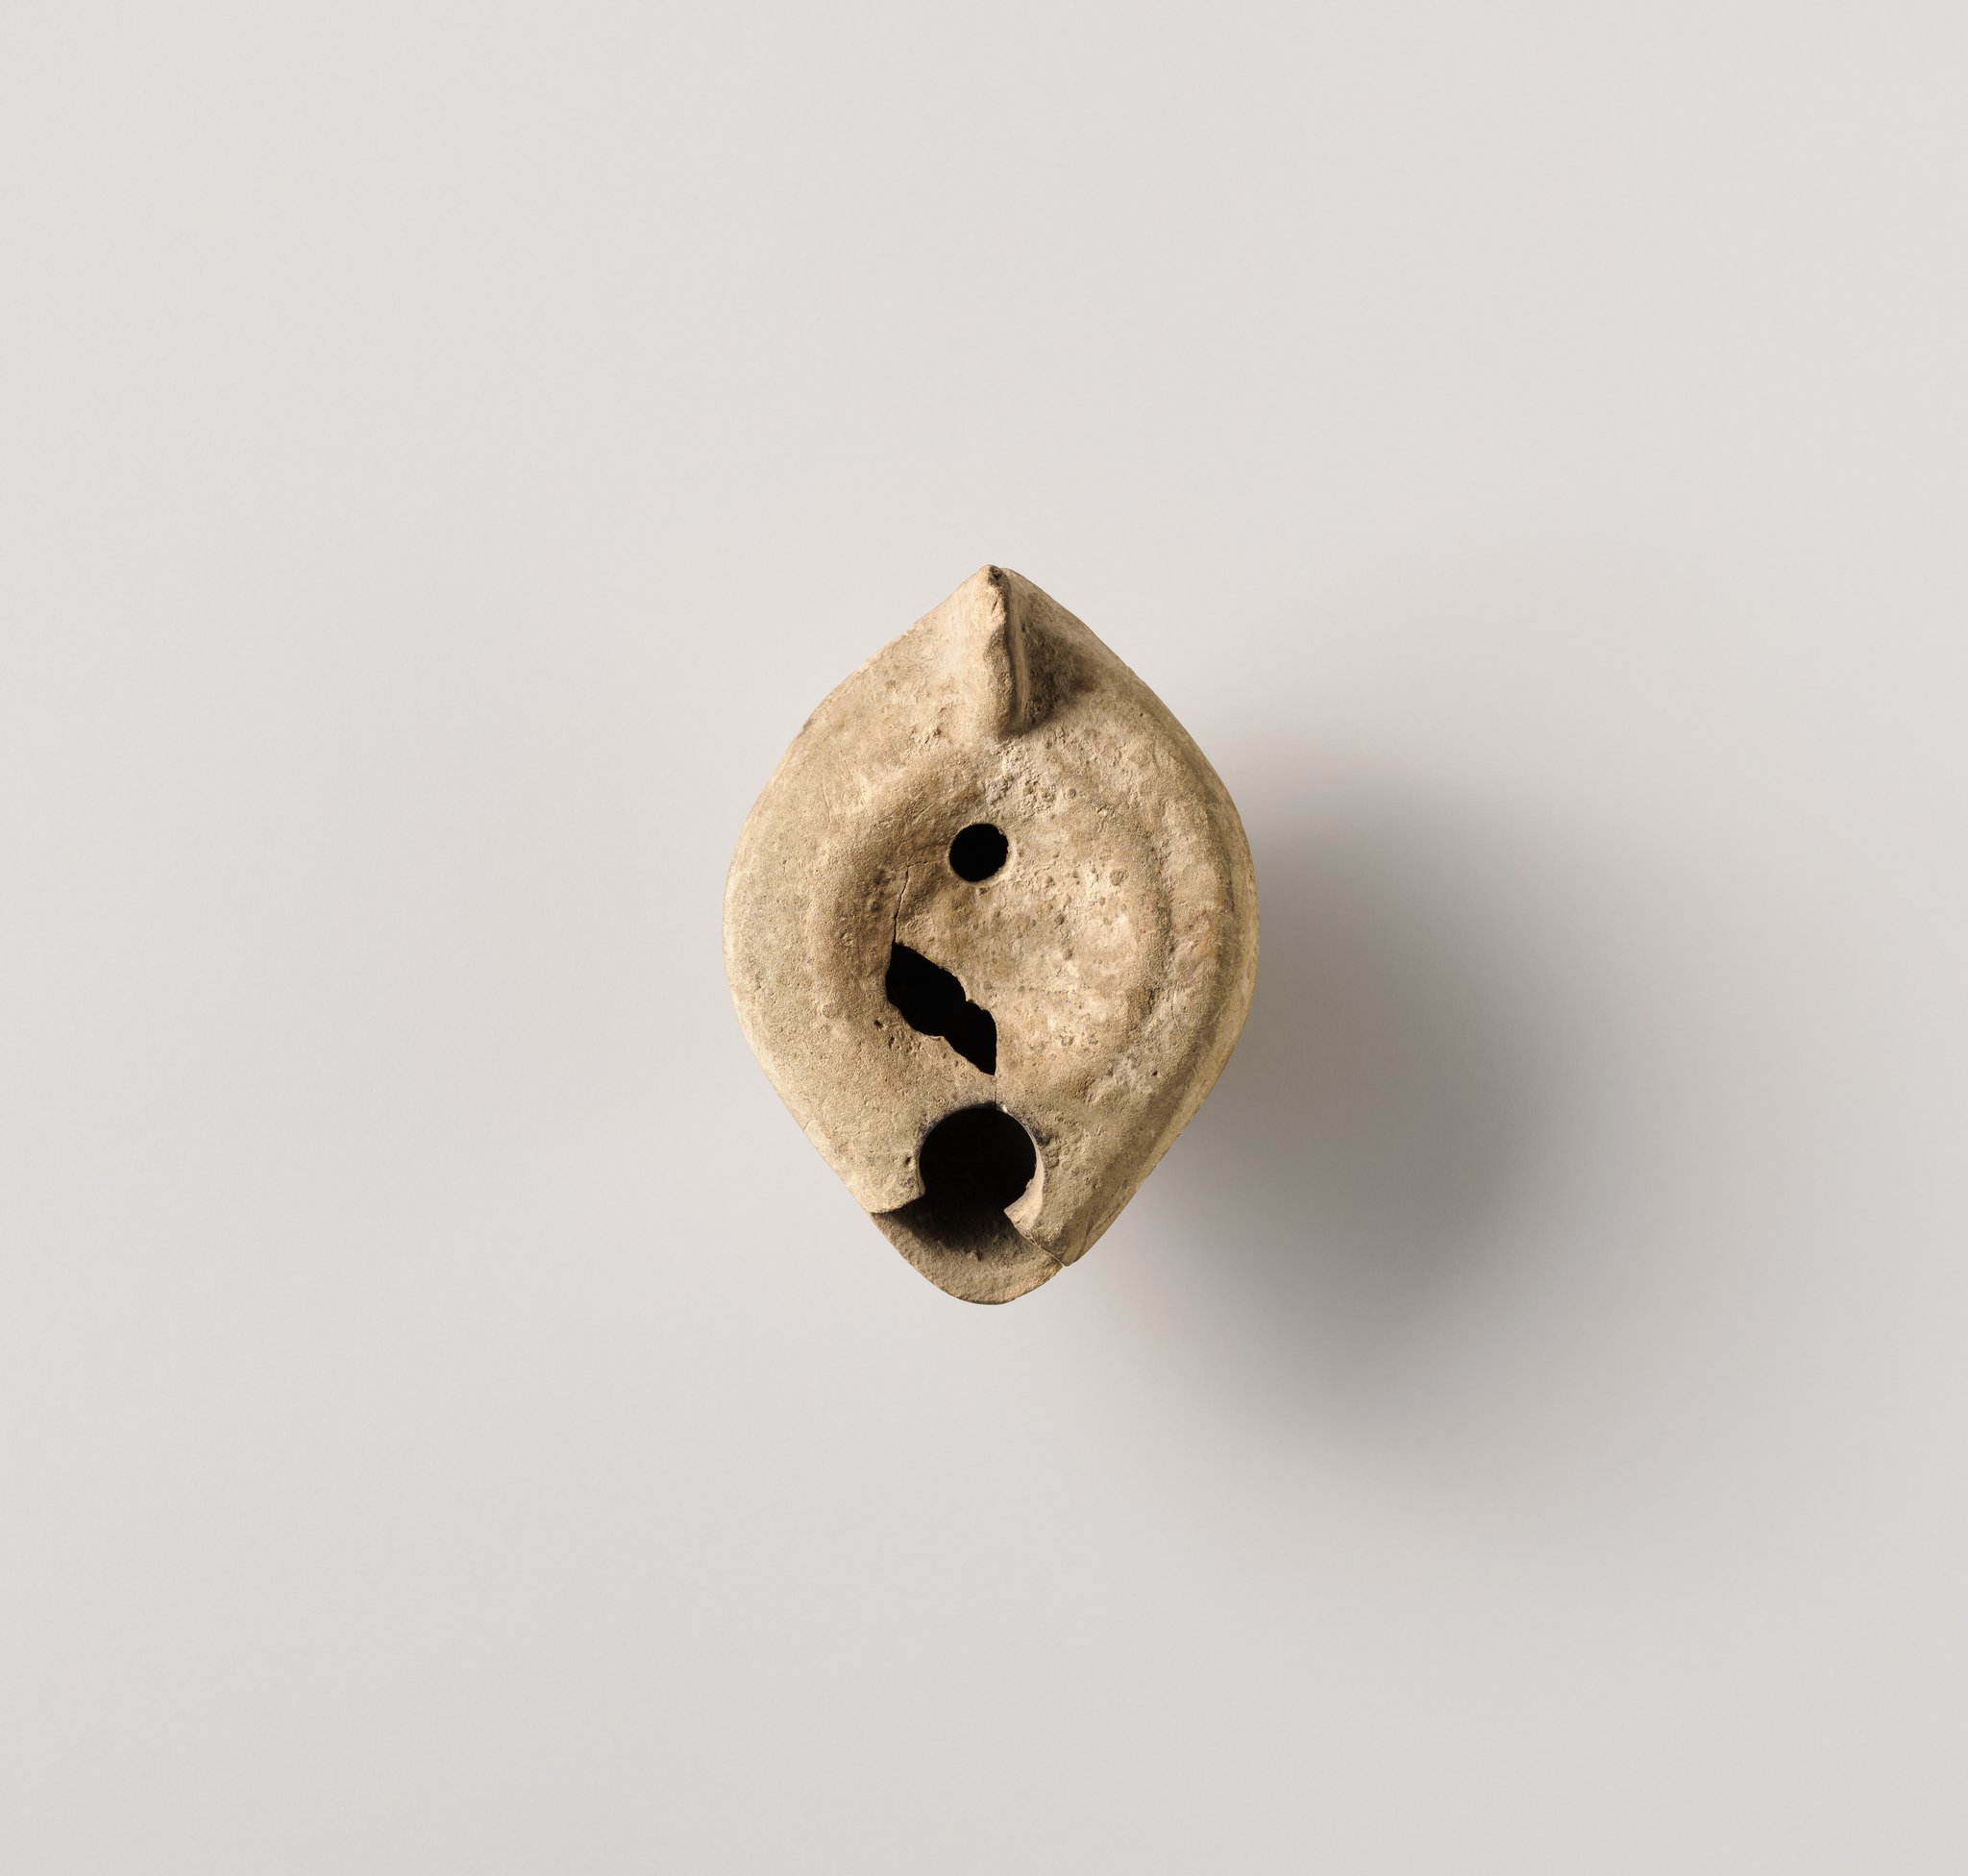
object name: lamp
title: Terracotta oil lamp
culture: roman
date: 301-500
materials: terracotta